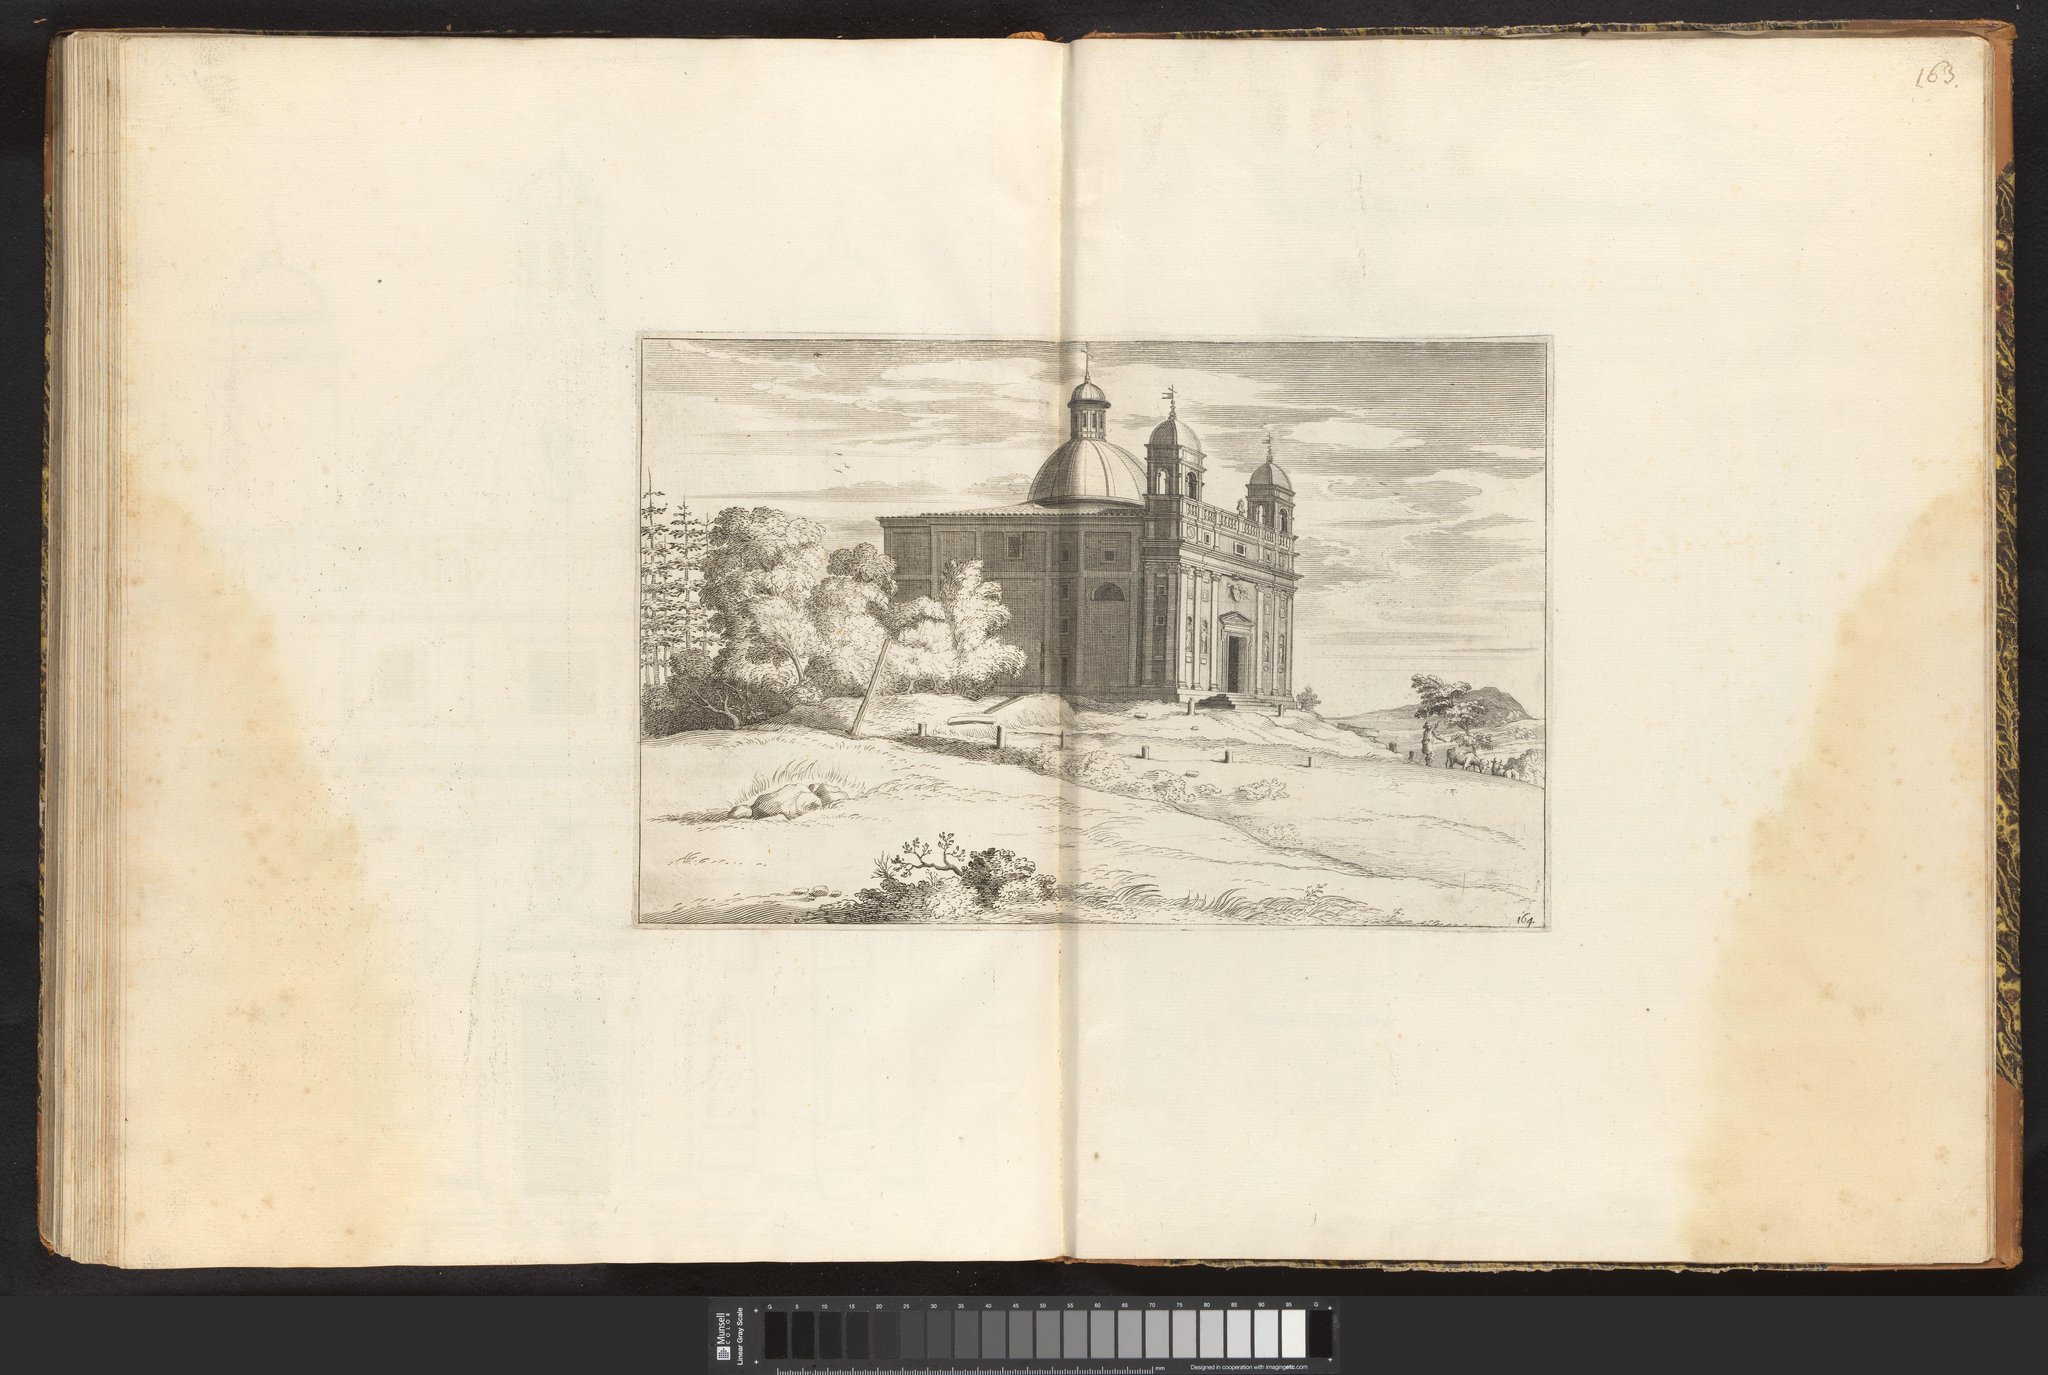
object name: print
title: Antieke vaas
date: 1636-1647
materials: paper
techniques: engraving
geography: rome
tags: vase ~ ornament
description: Antieke vaas. Prent maakt deel uit van een album met een serie prenten naar de sculpturen in de verzameling in de Galleria Giustiniani te Rome.